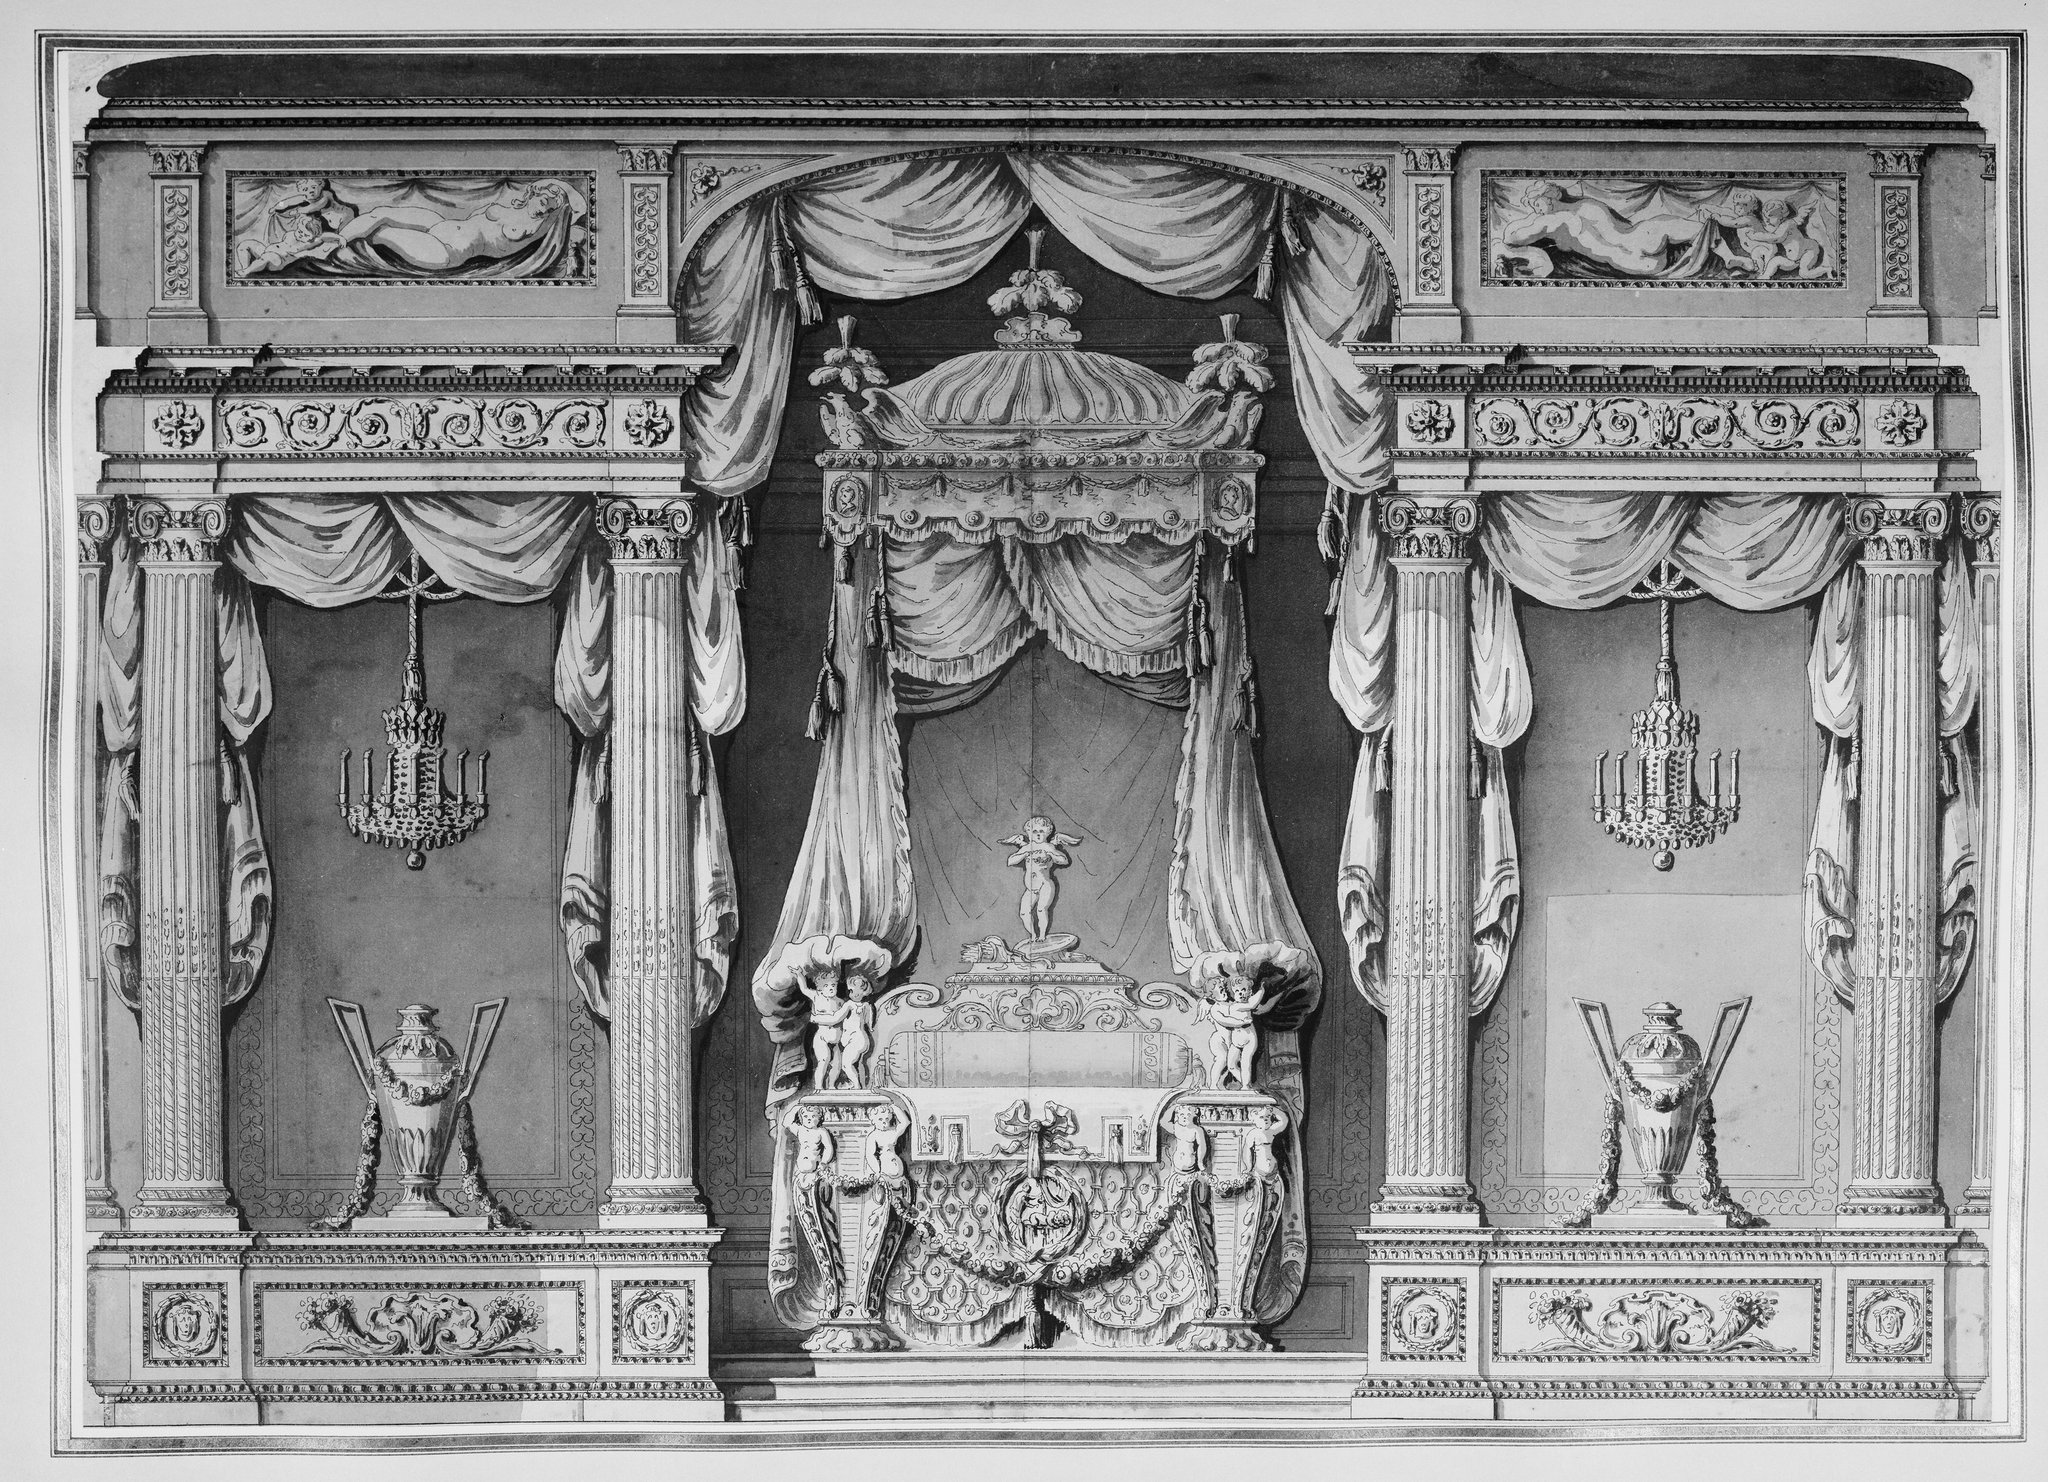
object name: drawing collection ornament architecture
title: Design for a Canopy Bed in an Alcove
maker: anonymous, french, 18th century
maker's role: artist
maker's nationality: french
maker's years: 1700-1800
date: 1770-1790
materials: ink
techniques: brush, pen, wash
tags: columns,cupid,beds